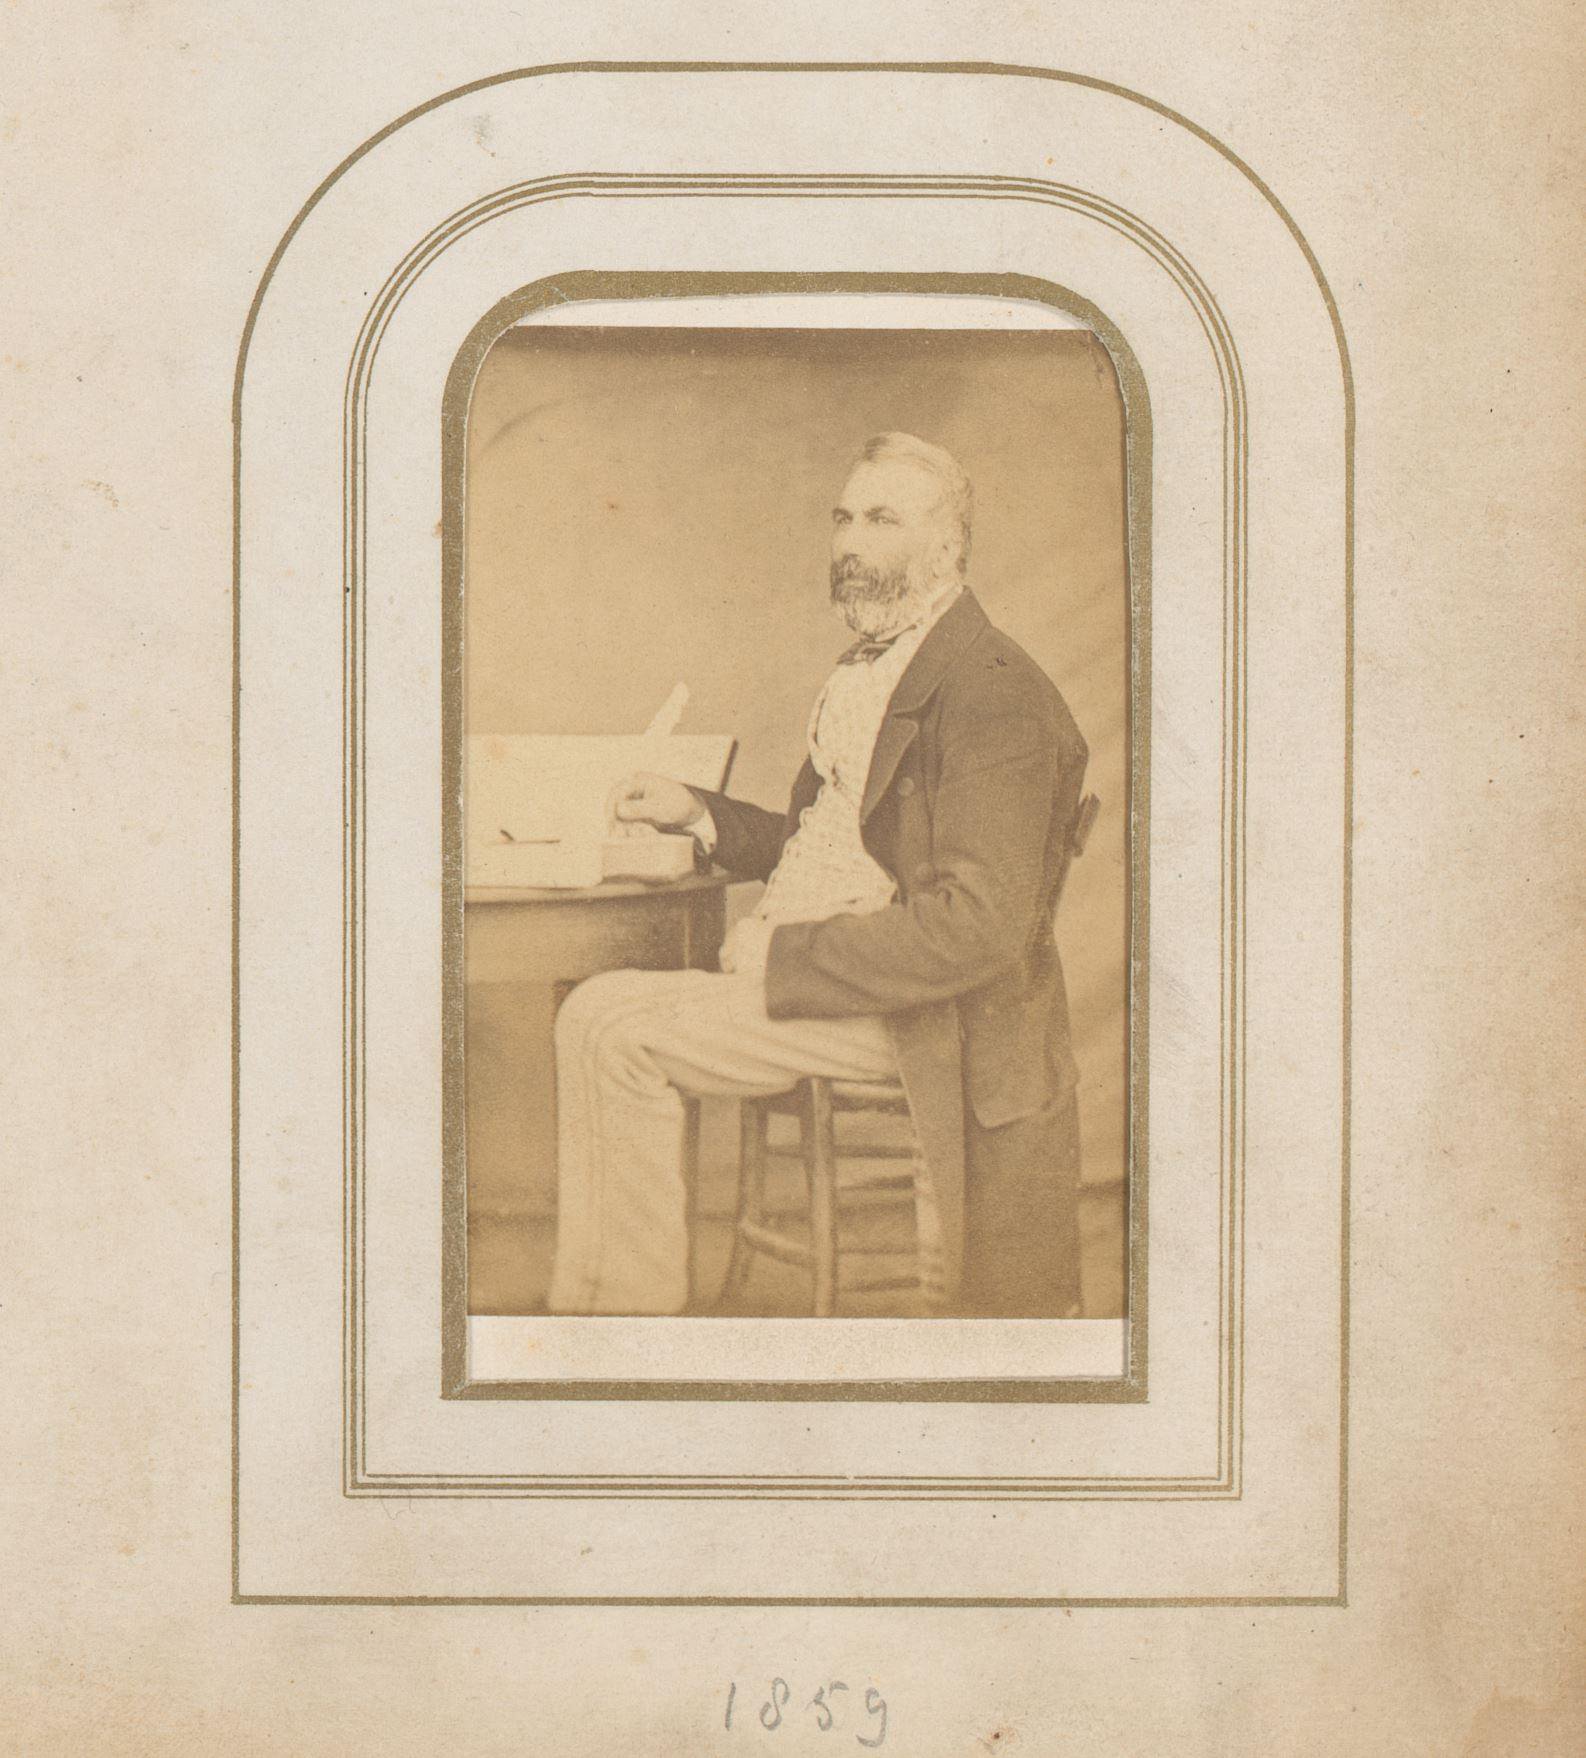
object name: album leaf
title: Portret van een man, zittend aan een tafel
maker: jules géruzet (fotograaf)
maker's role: fotograaf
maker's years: 1817-1874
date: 1859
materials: cardboard, photographic support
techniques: albumen print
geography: brussels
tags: sitting figure, historical persons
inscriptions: inscription: ‘Atelier de Photographie/ de J. Géruzet, Edituer d'Estampes/ 27 bis, Rue de l'Ecruyer/ Bruxelles’